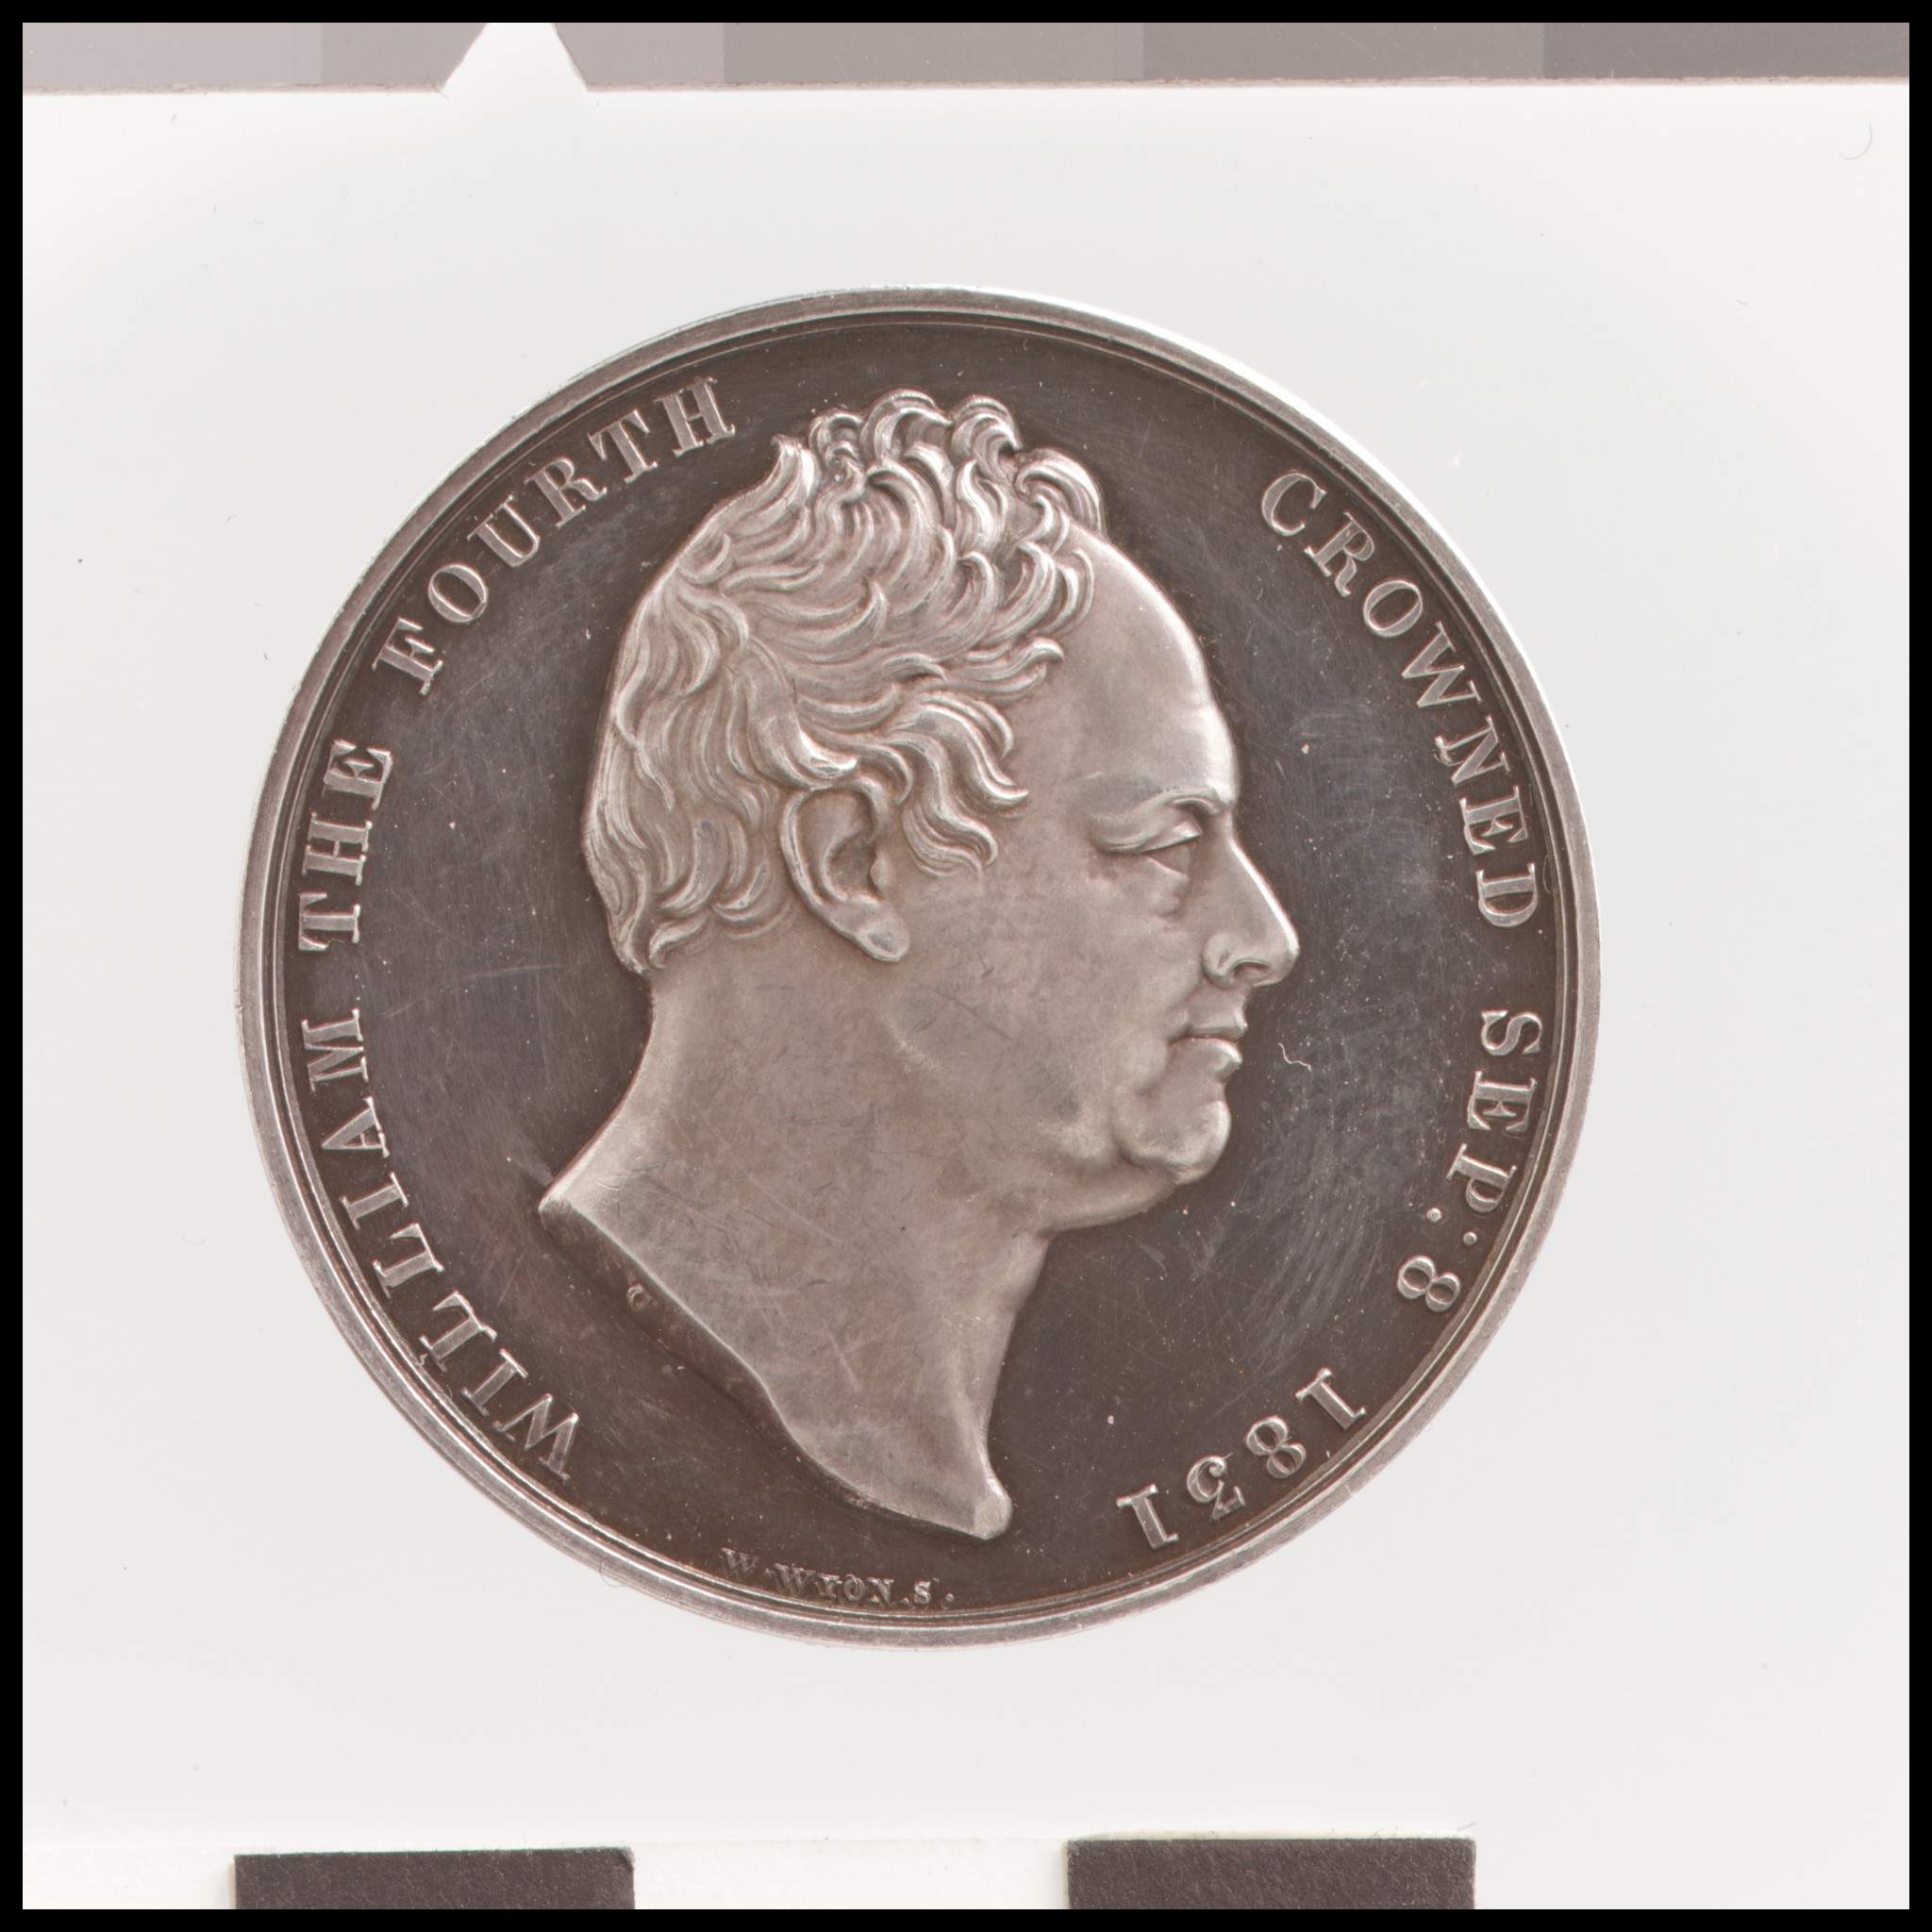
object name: medal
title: Coronation of William IV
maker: william wyon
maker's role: artist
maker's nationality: british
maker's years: 1795-1851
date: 1831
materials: silver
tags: men,profiles